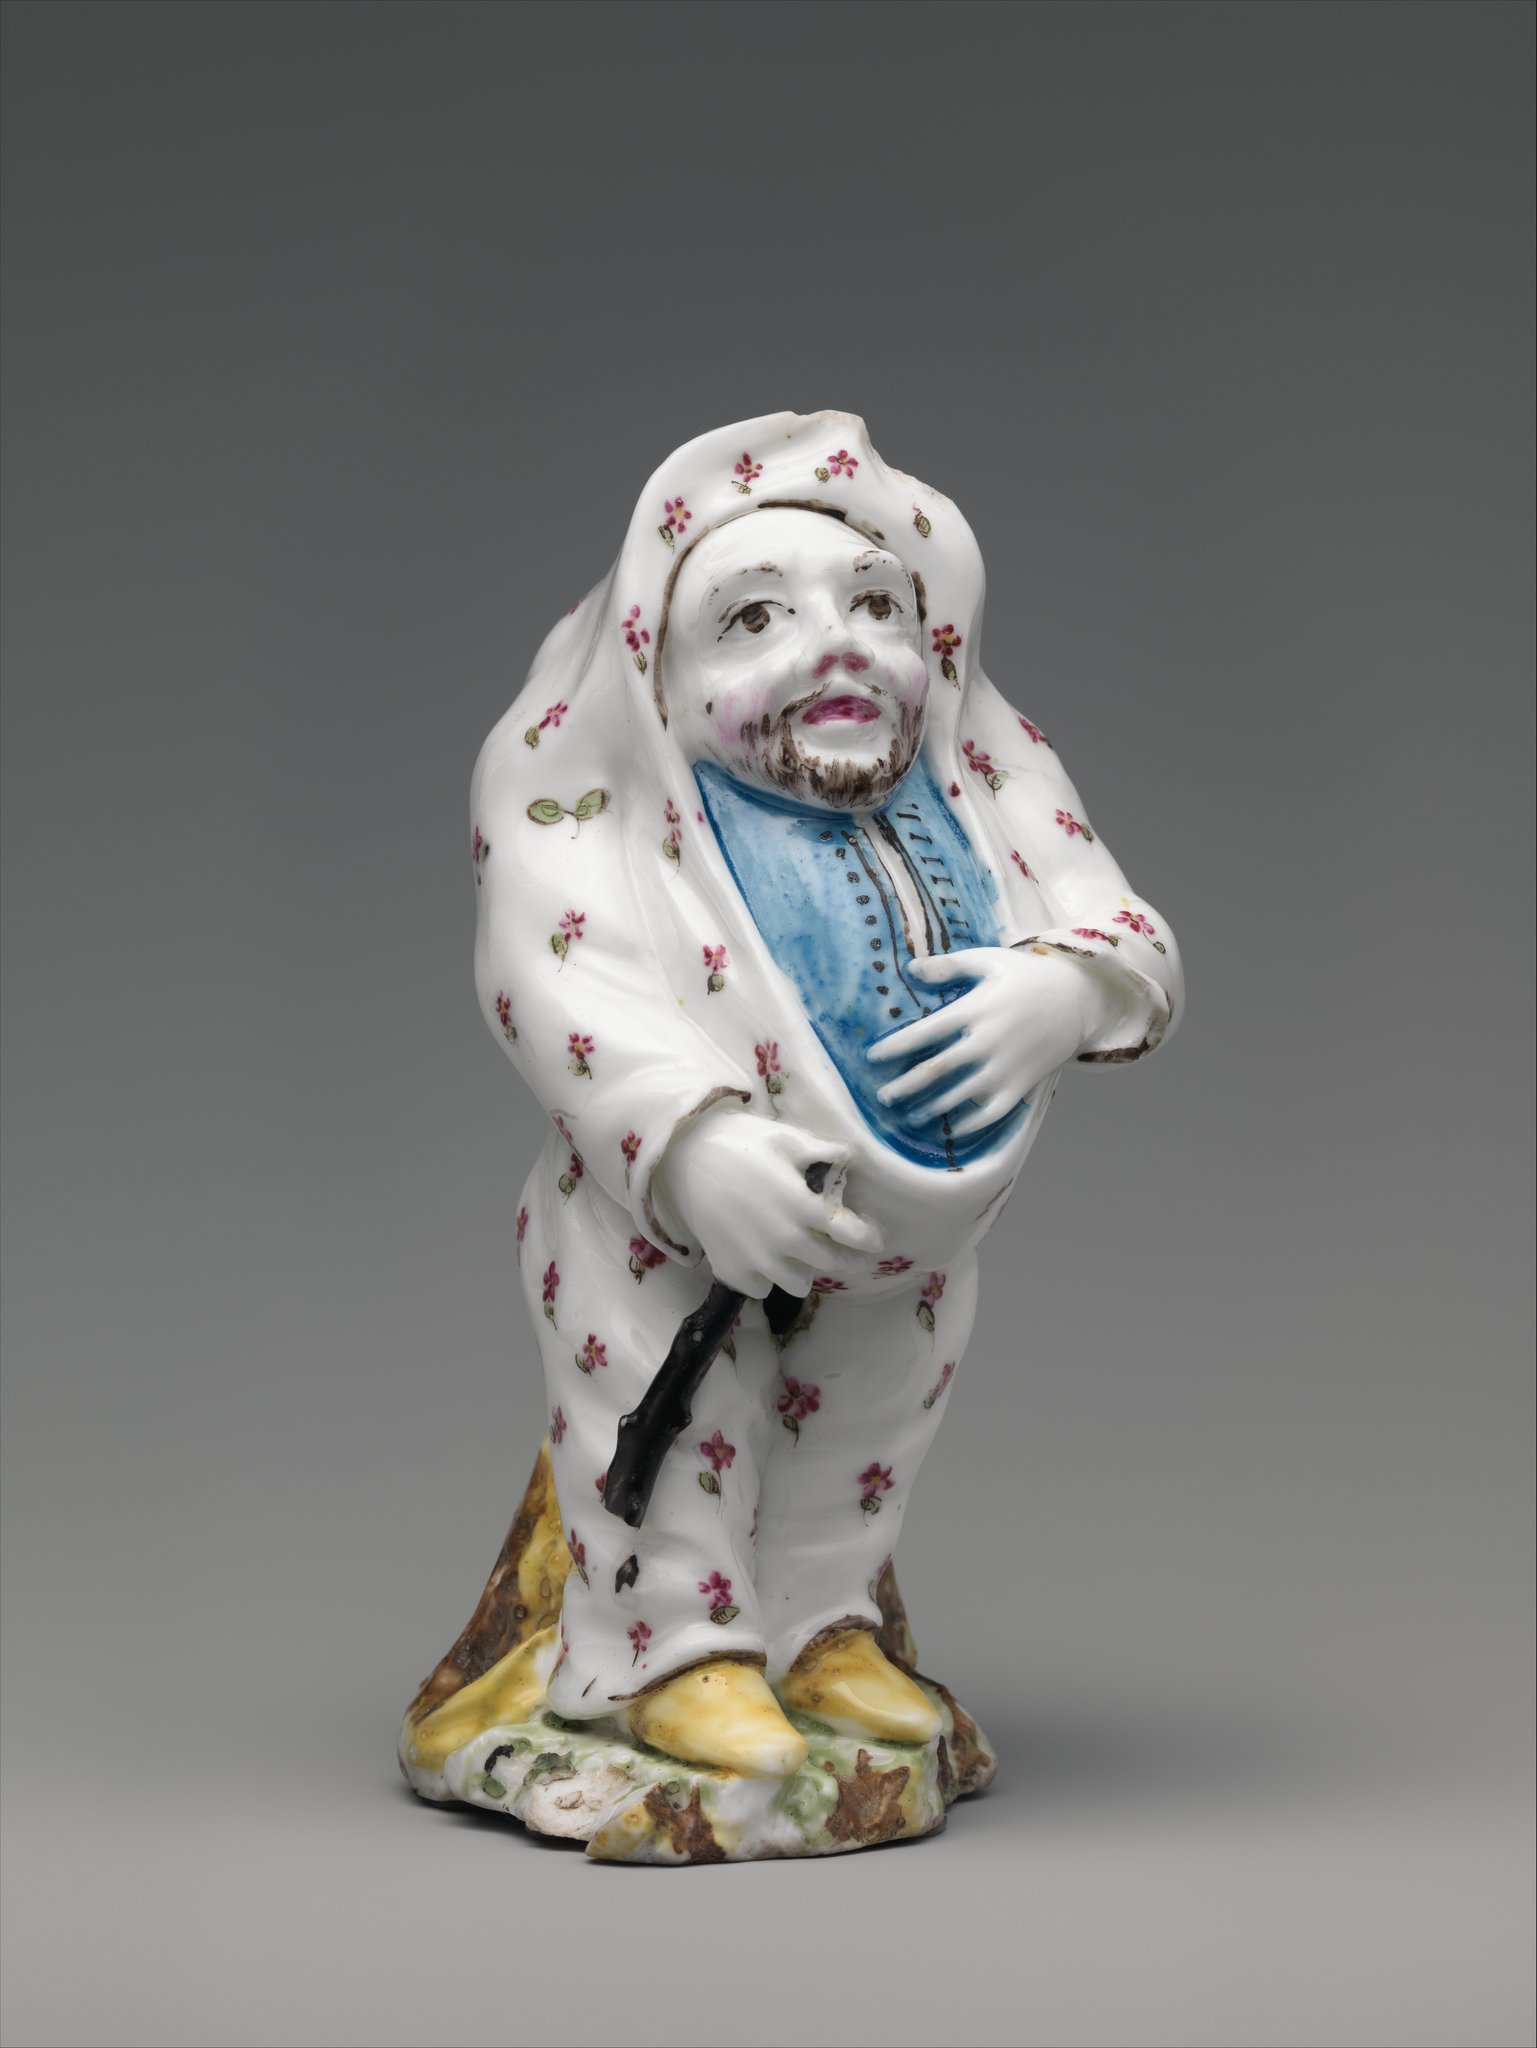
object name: figure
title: Hunchback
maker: mennecy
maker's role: factory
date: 1750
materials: soft paste porcelain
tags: men